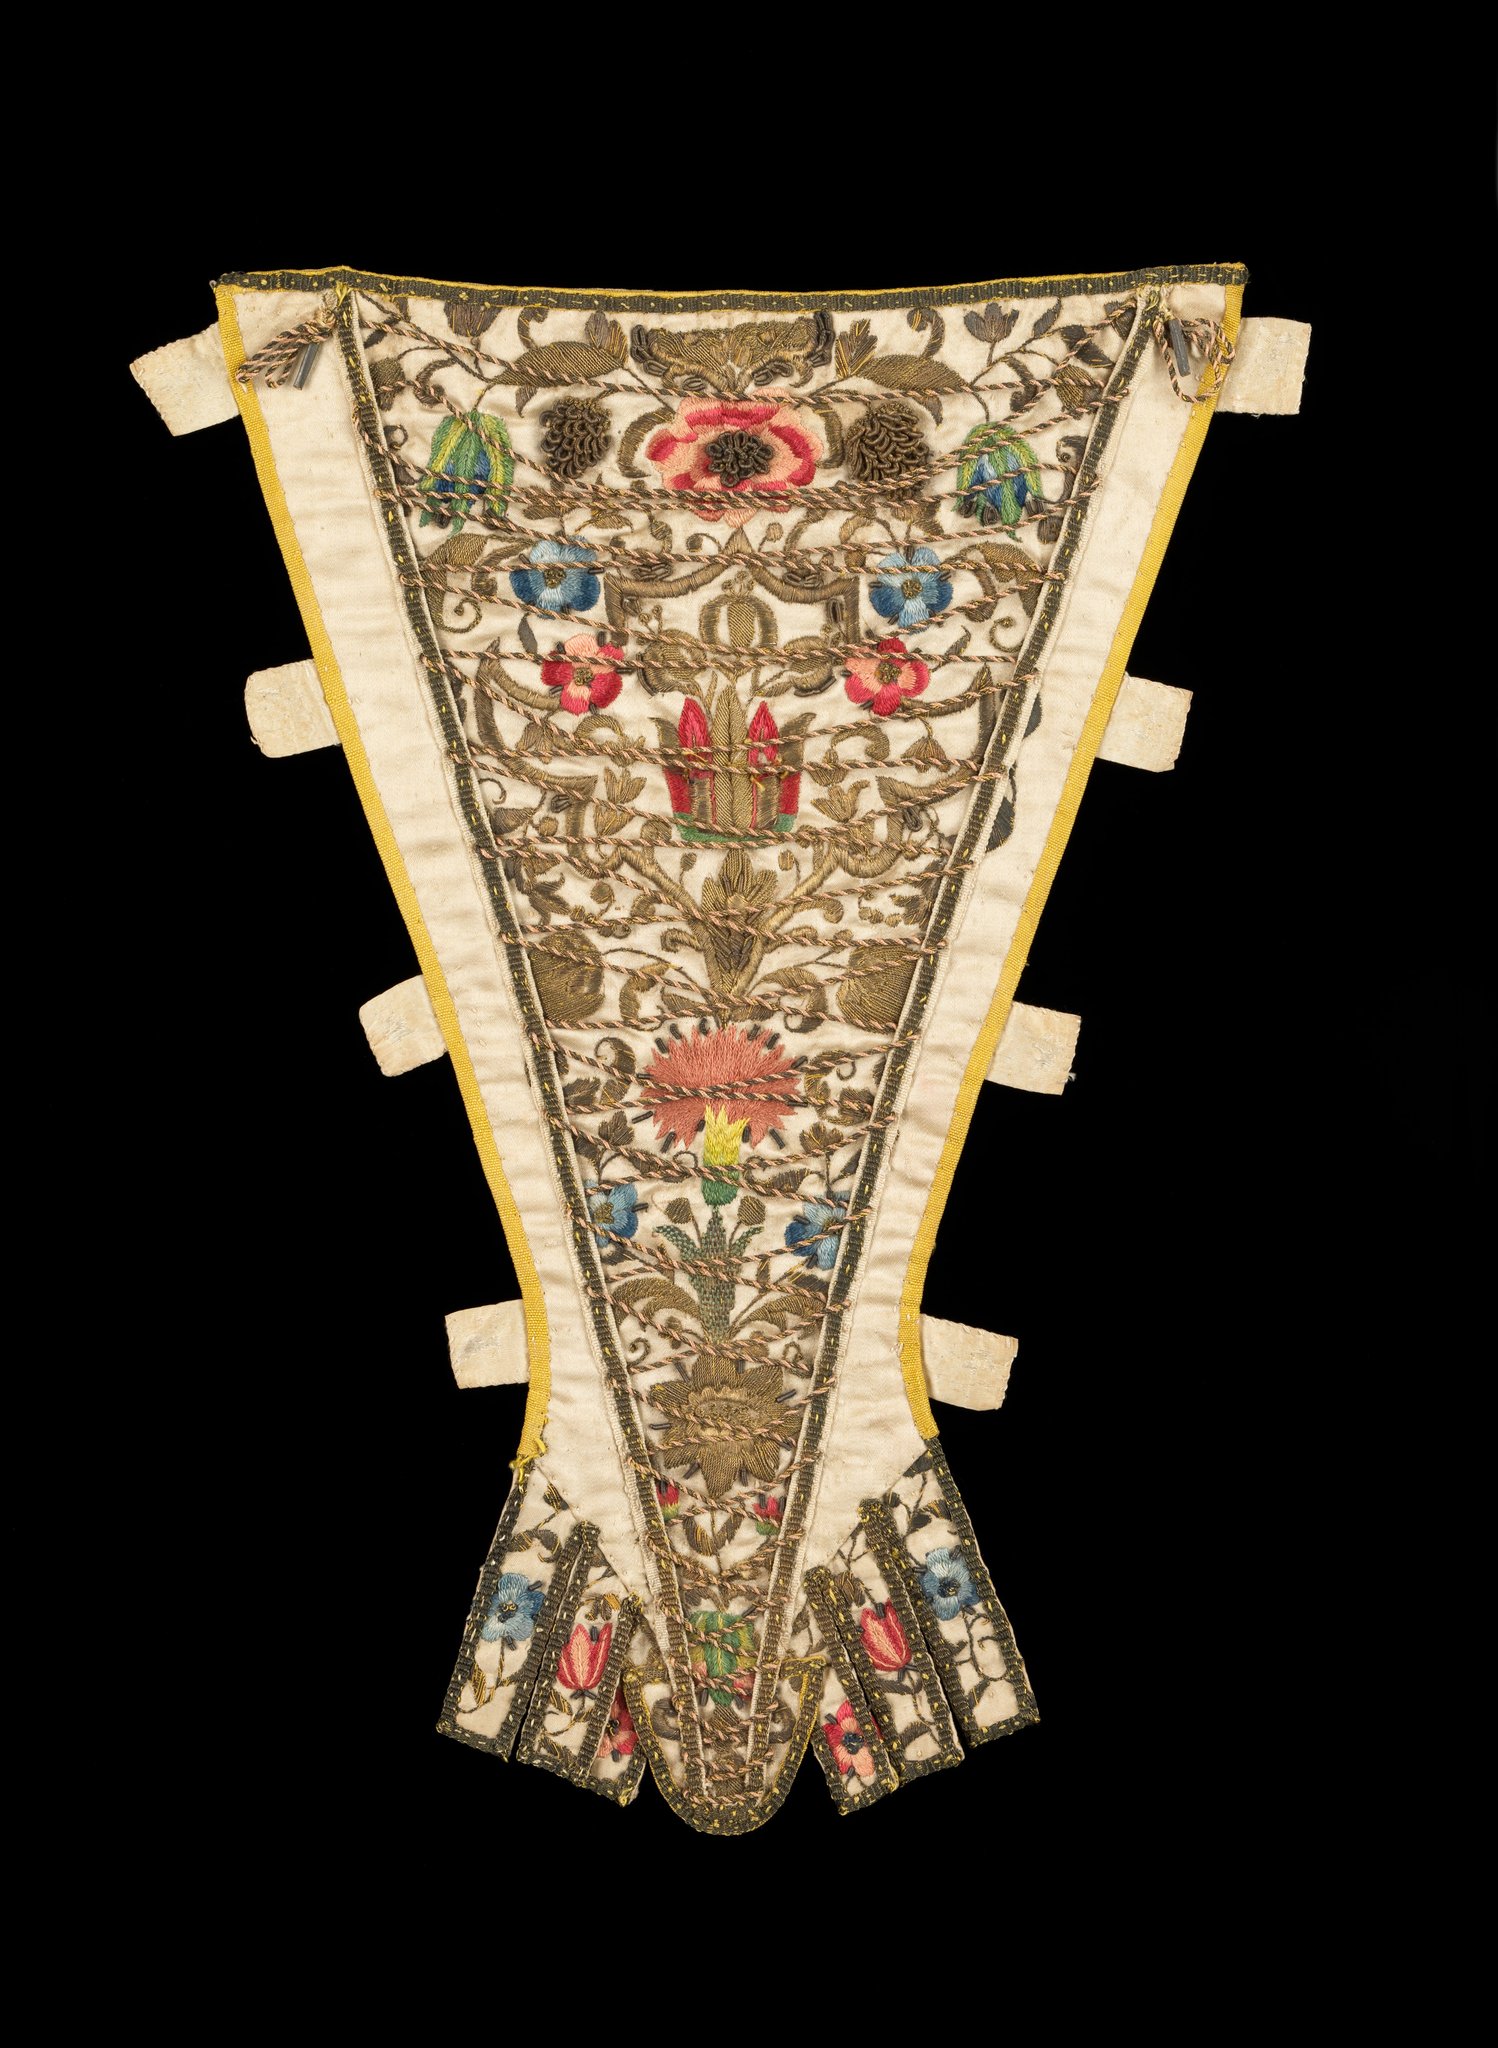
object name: stomacher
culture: british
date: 1720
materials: metal, silk